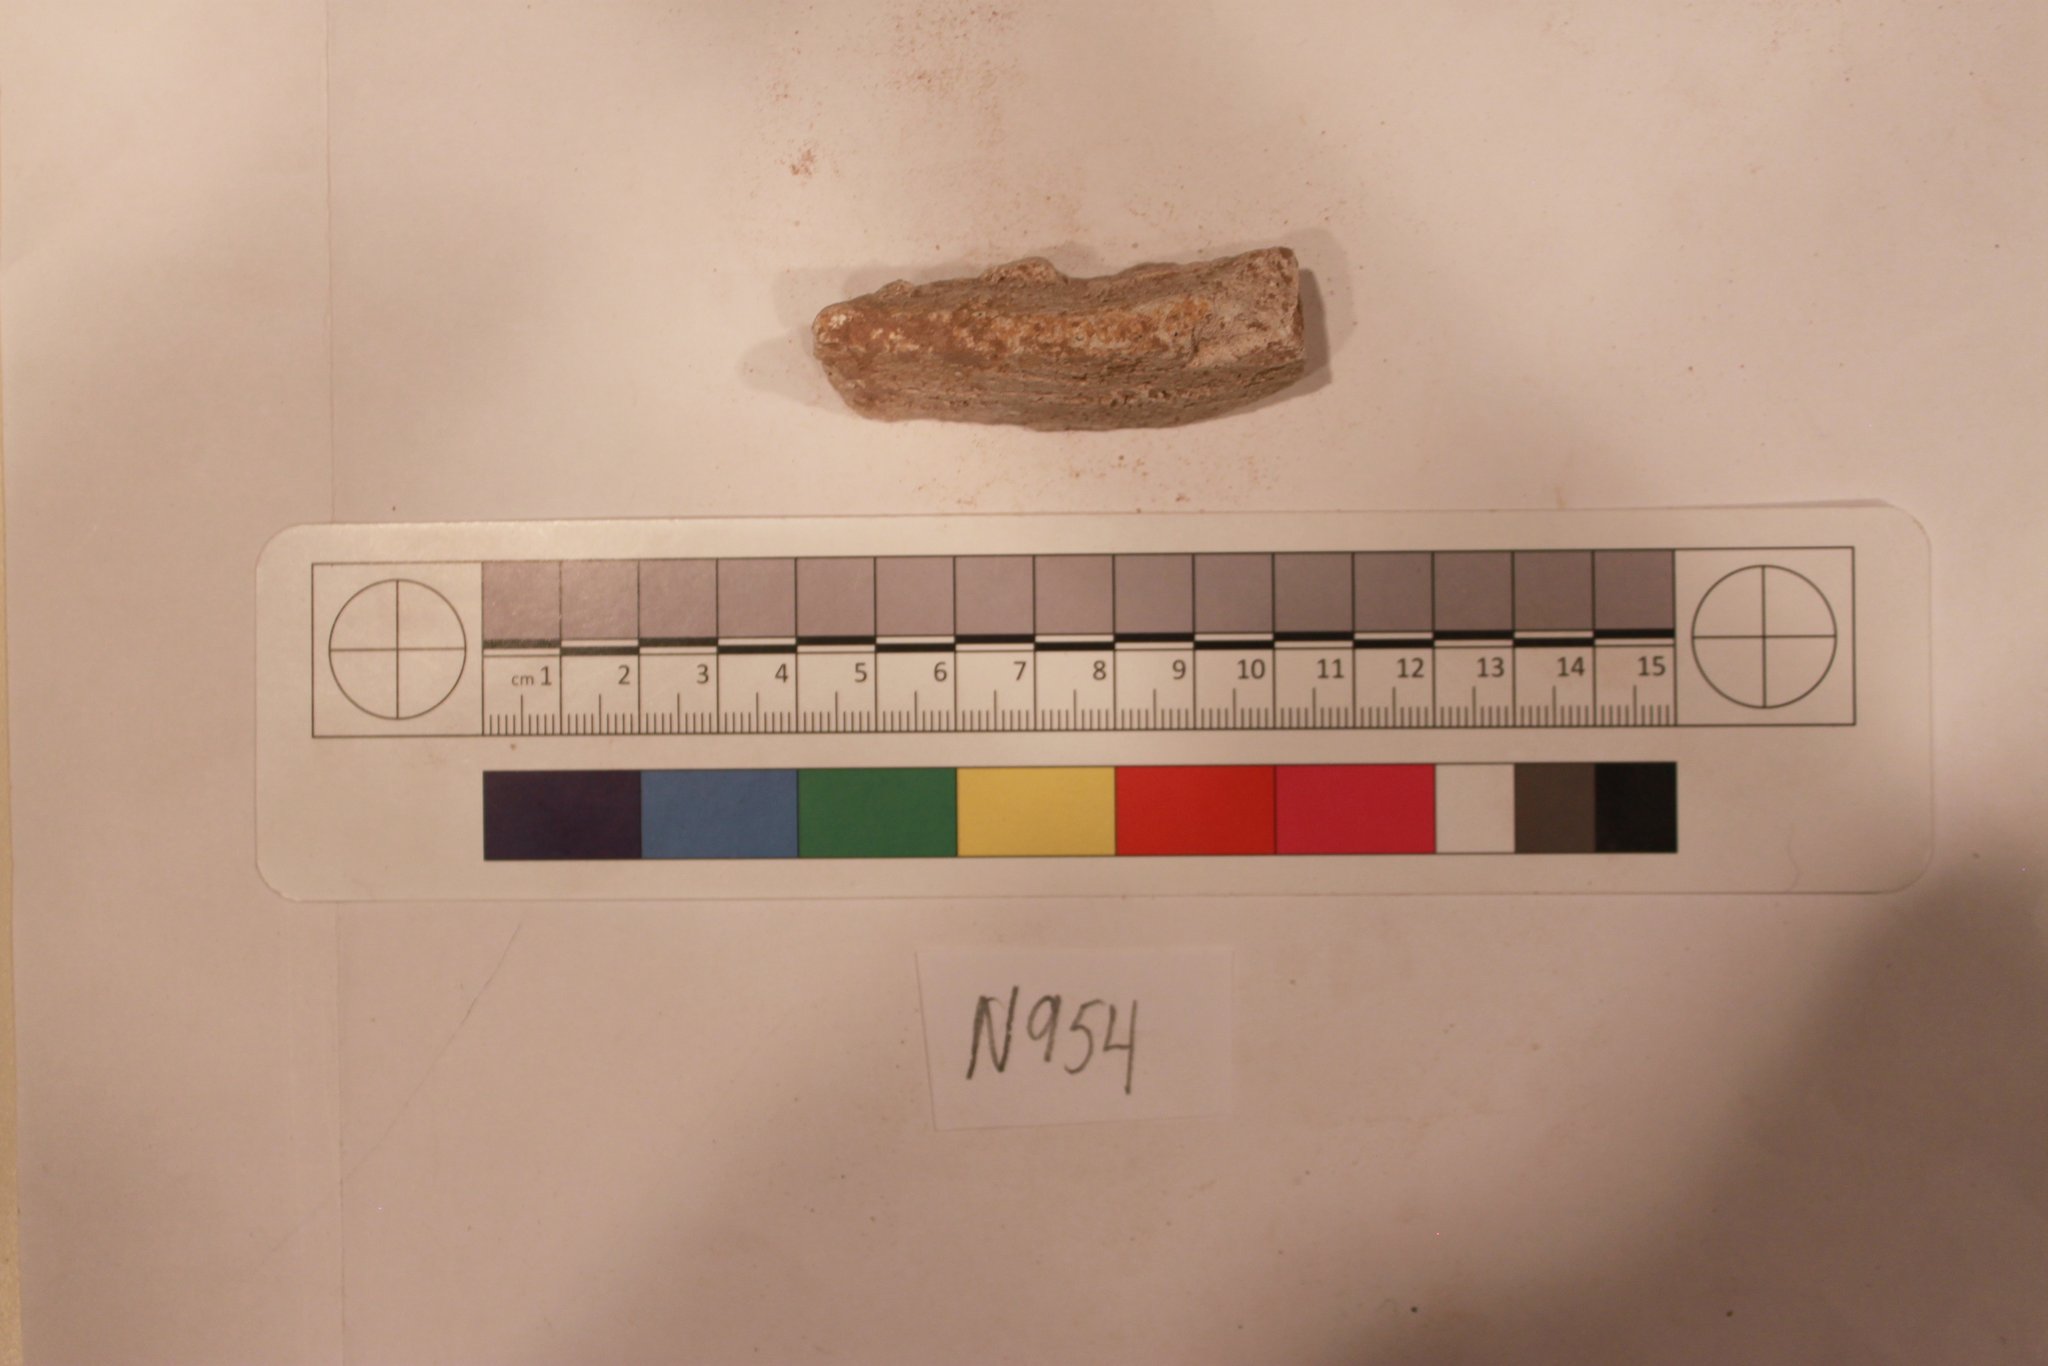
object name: fragment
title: Stucco Fragment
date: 701-1200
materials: plaster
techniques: carving, painting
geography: iran